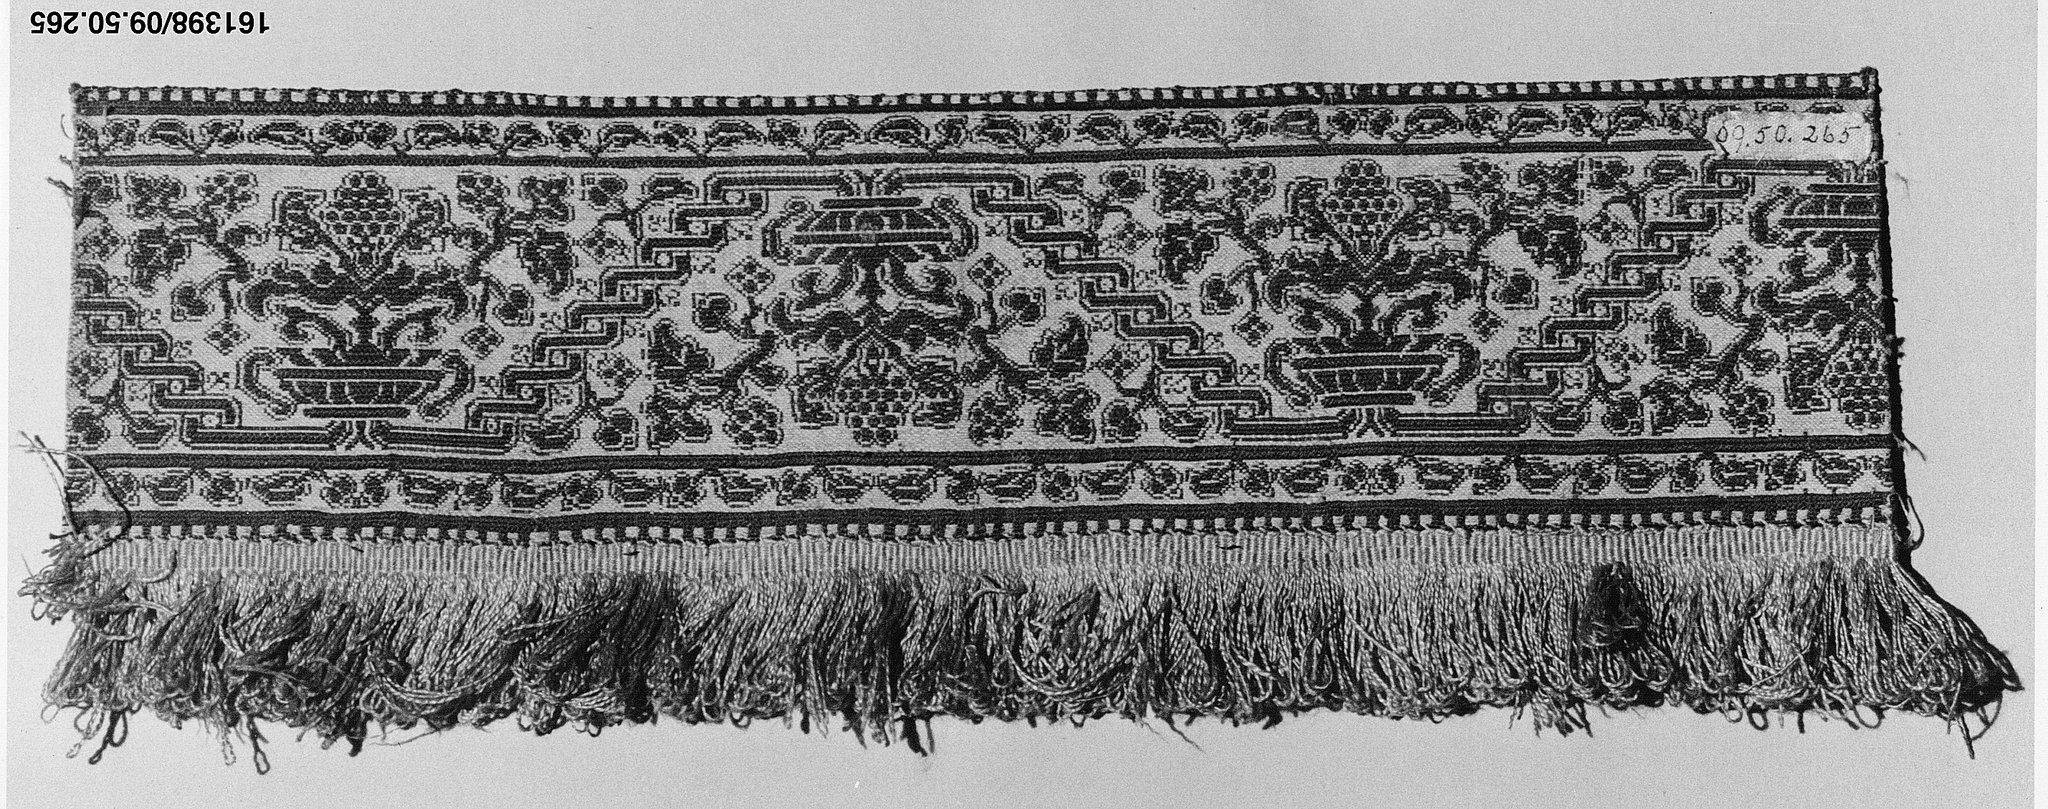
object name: band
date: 1501-1600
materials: silk